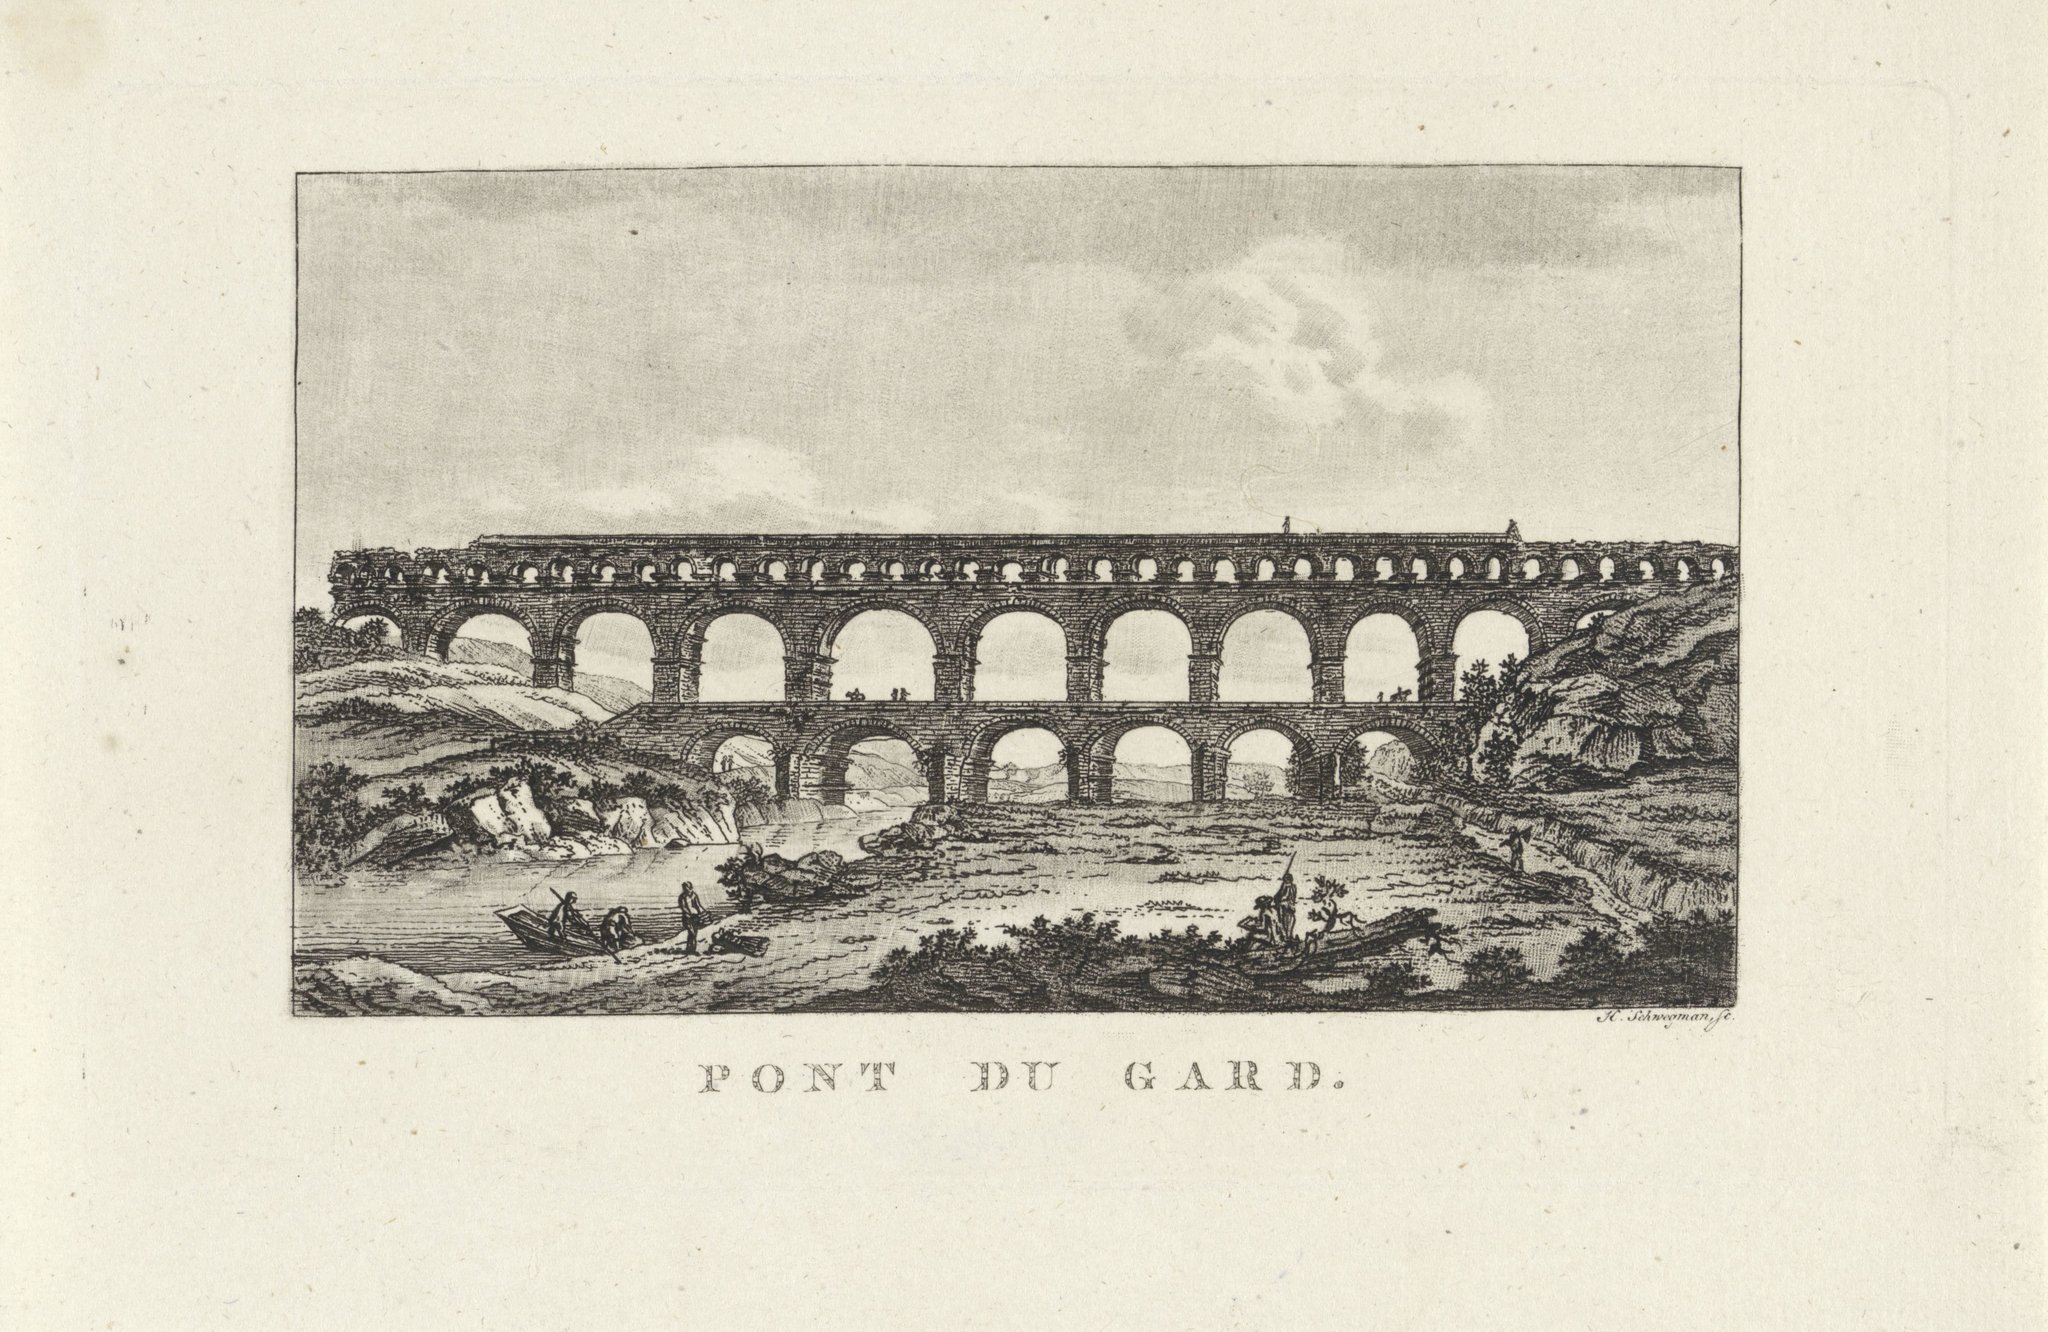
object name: print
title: Gezicht op Pont du Gard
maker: hendrik schwegman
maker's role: draughtsman, print maker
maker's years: 1761-1816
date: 1771-1816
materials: paper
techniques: etching, roulette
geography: haarlem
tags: landscape with bridge, viaduct or aqueduct, aqueduct (~ water supply)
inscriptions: collector's mark: Lugt 2228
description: Gezicht op het Romeinse aquaduct Pont du Gard.